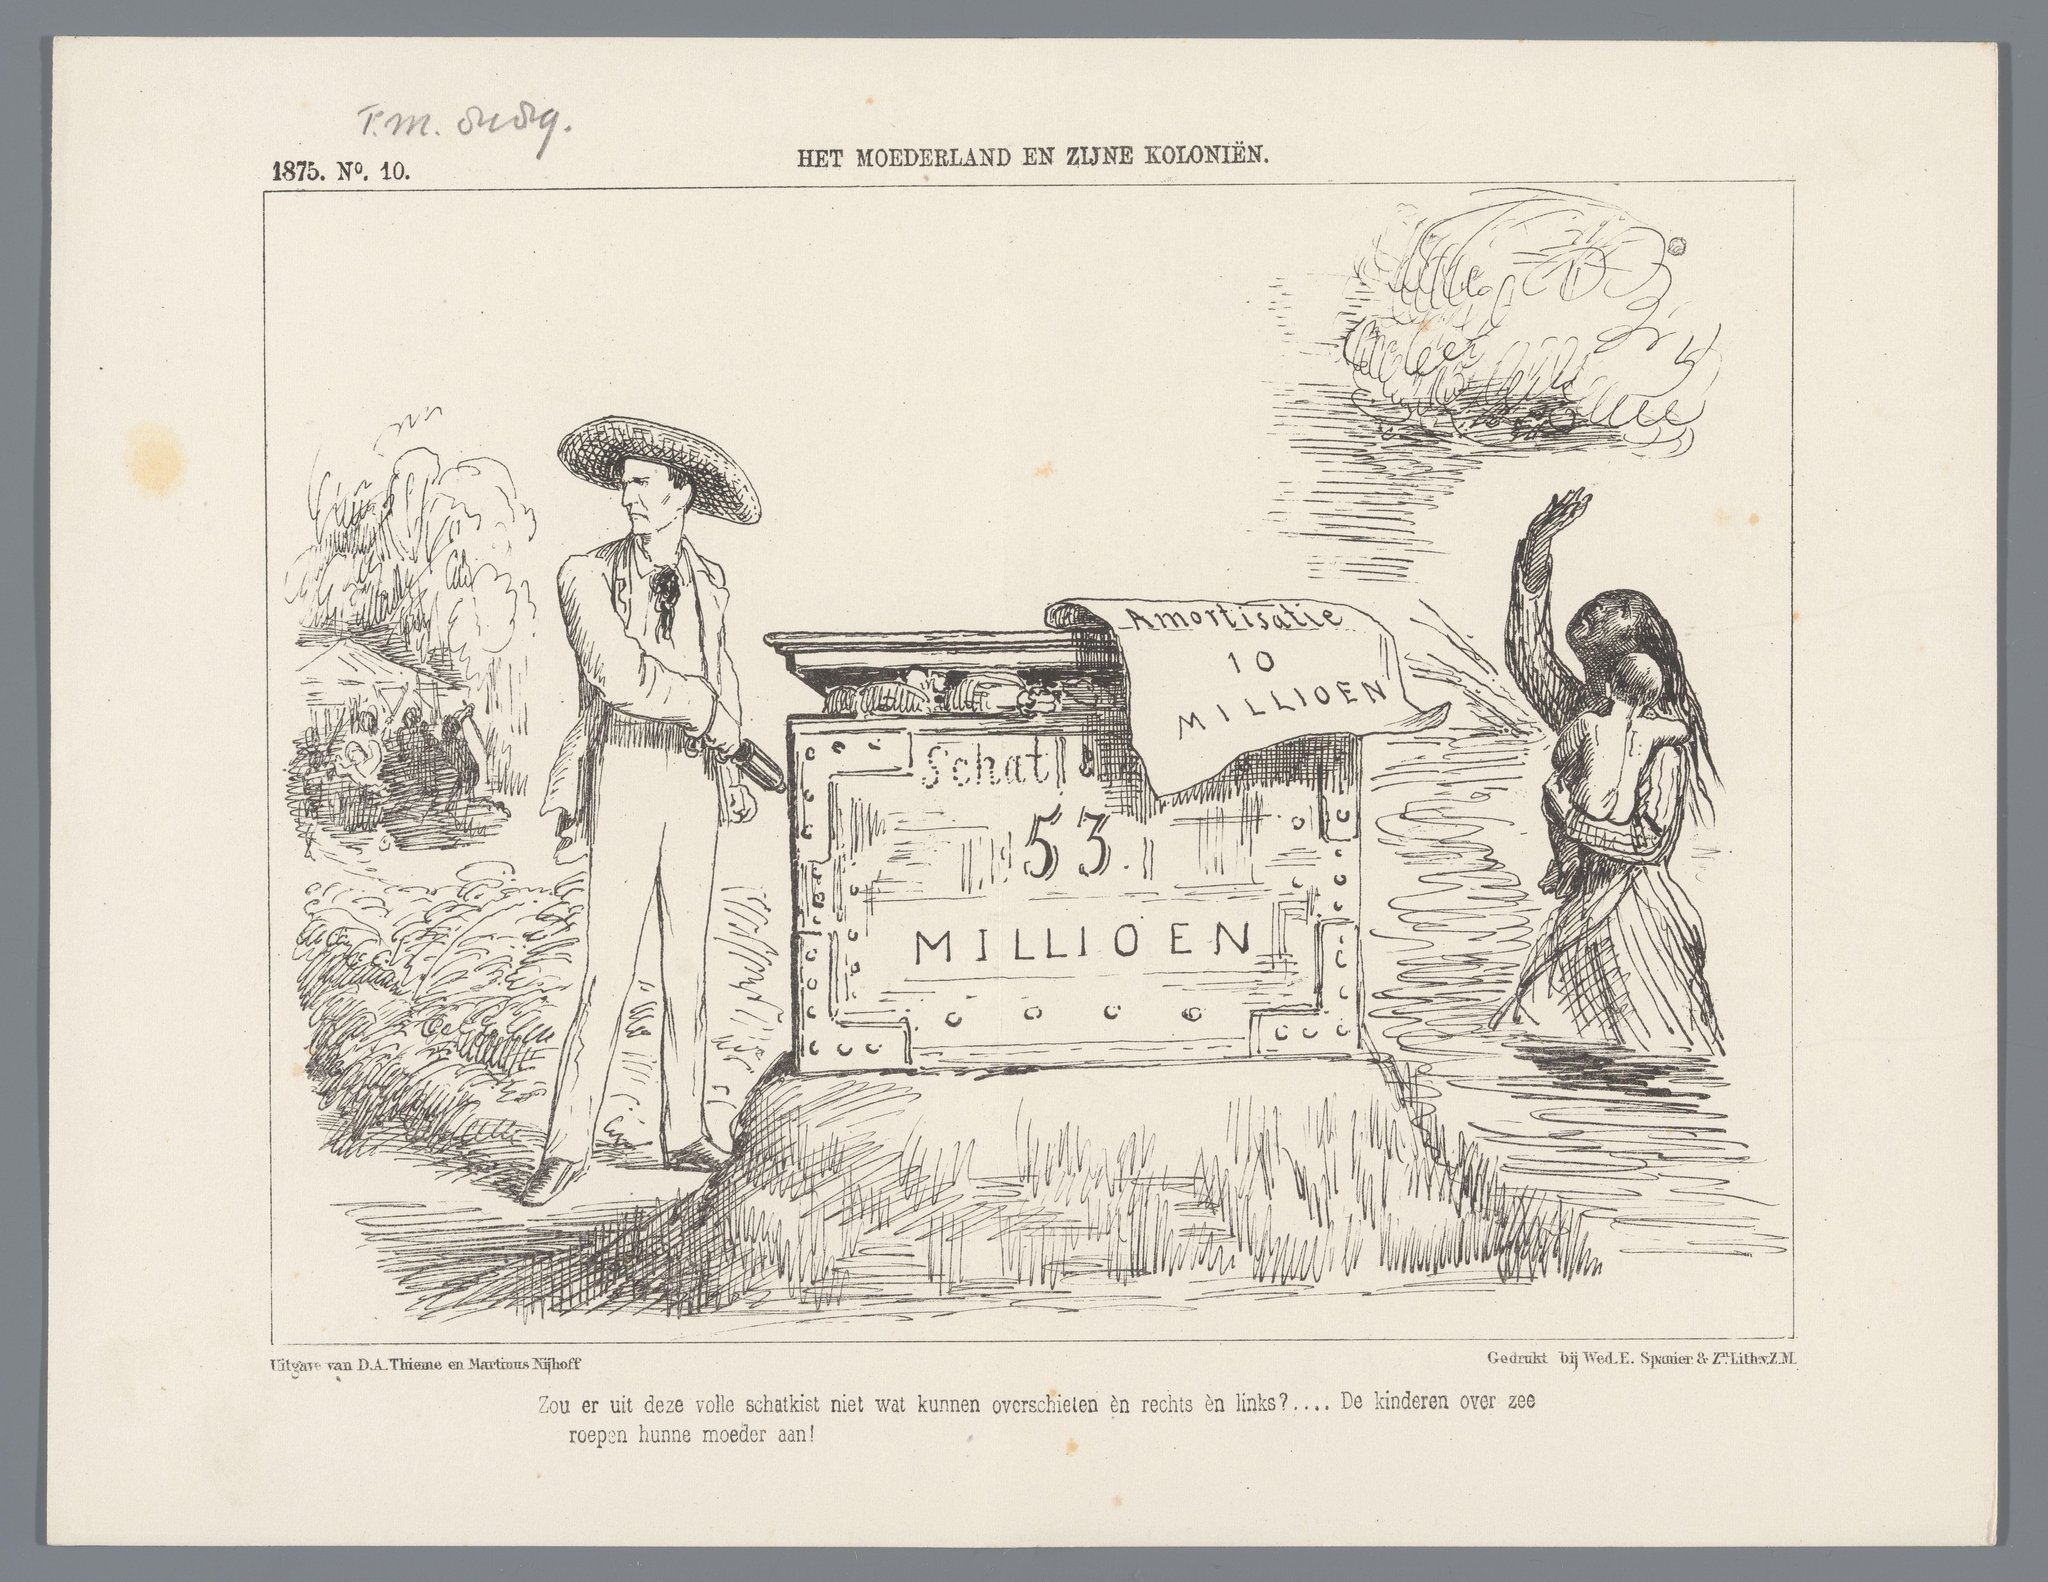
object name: print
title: Het moederland en zijne koloniën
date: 1875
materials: paper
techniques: lithograph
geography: arnhem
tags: suriname, java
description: Spotprent op de plannen tot aflossing van de nationale schuld, welke gelden sommigen liever besteed zagen in Oost- en West -Indië. Rechts een Javaanse vrouw, links een Surinaamse planter met een revolver. Plaat verschenen bij het weekblad De Nederlandsche Spectator, nr. 10, 1875.